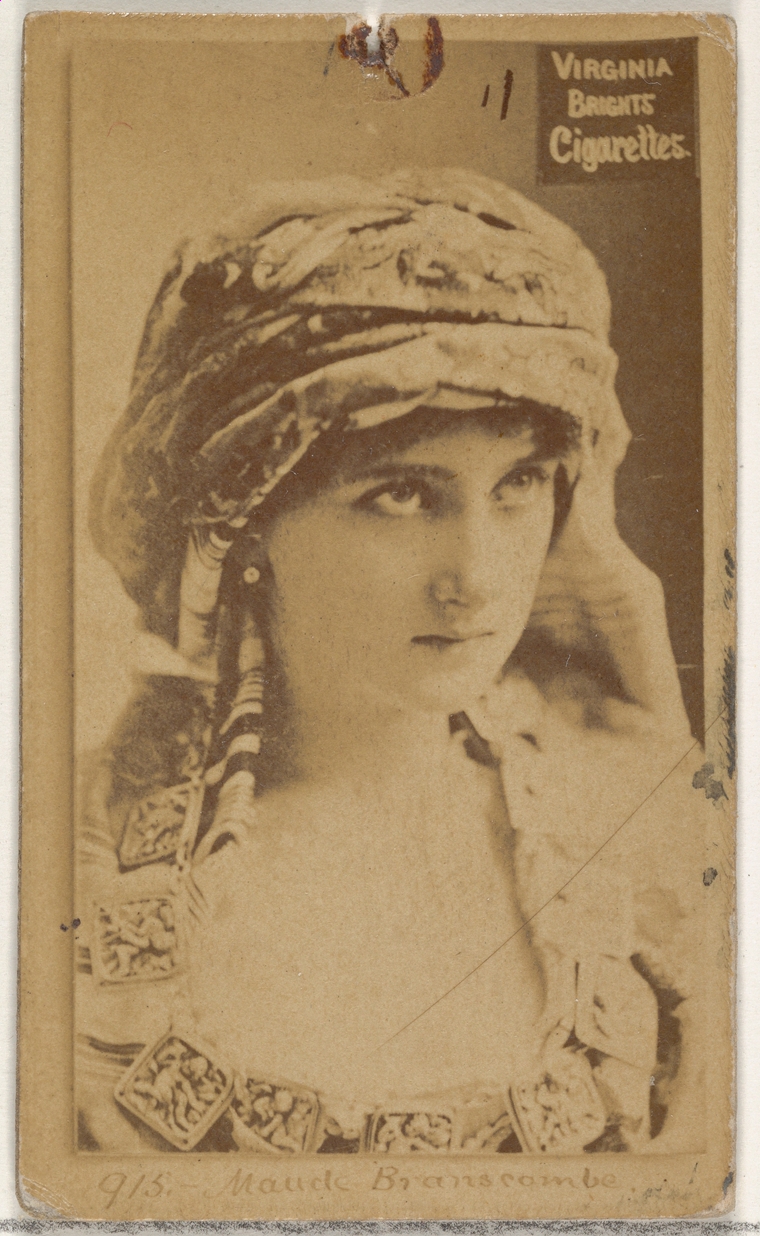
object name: photograph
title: Card 915, Maude Branscombe, from the Actors and Actresses series (N45, Type 2) for Virginia Brights Cigarettes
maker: allen & ginter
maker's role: publisher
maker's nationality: american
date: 1888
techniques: albumen silver print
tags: portraits,women,actresses